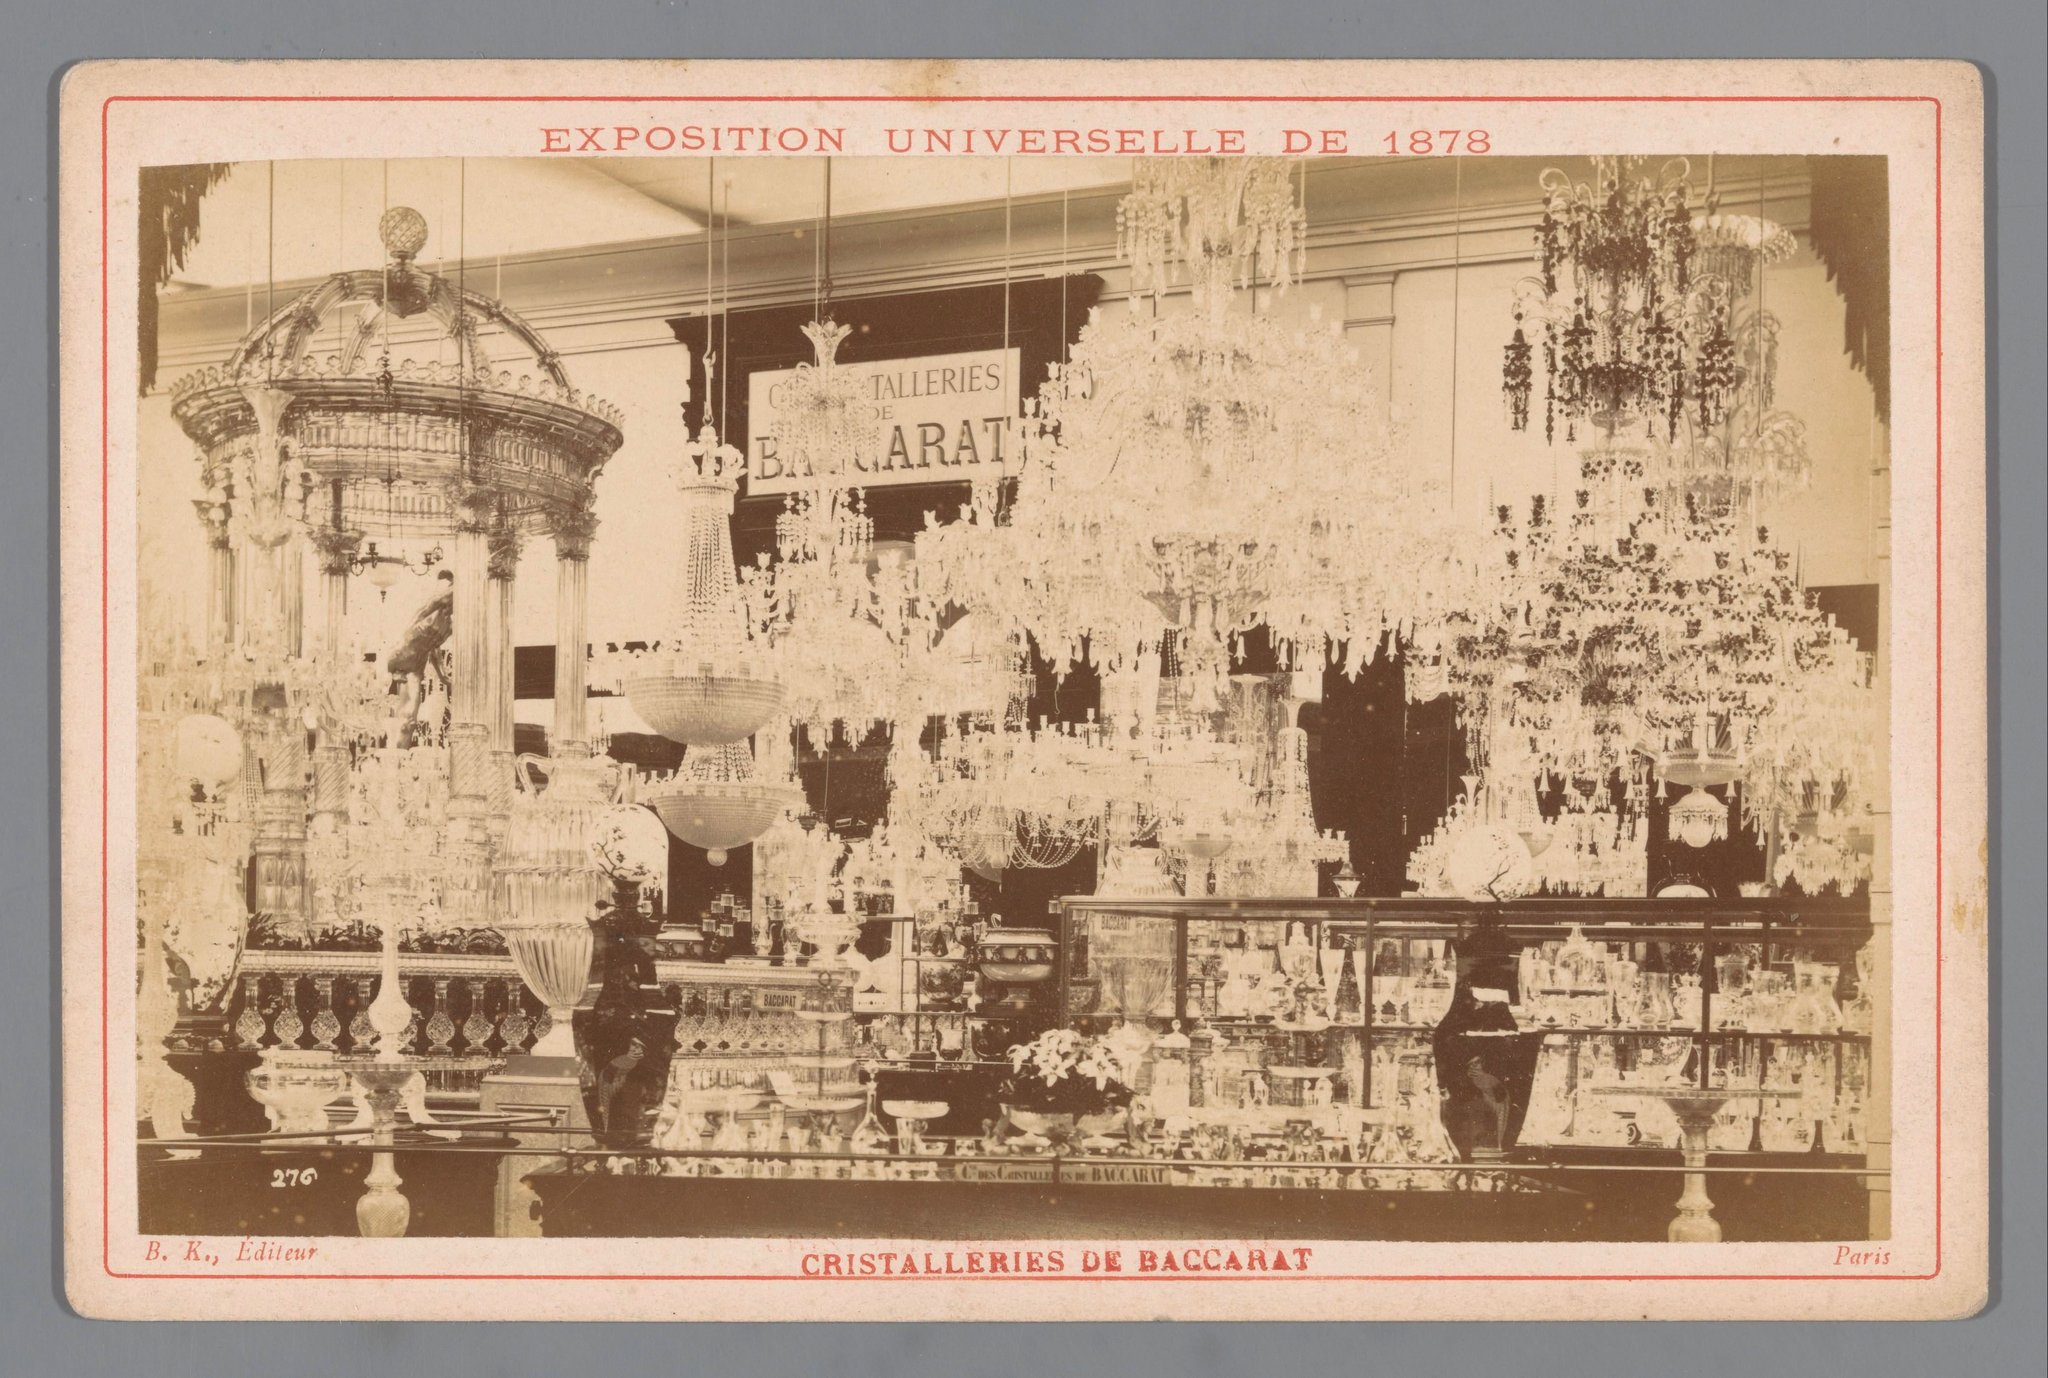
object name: photograph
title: Exposition Universelle de 1878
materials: cardboard, photographic support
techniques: albumen print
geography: paris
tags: world fair, world exhibition, chandelier, candelabrum, paris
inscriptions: number: ‘276’